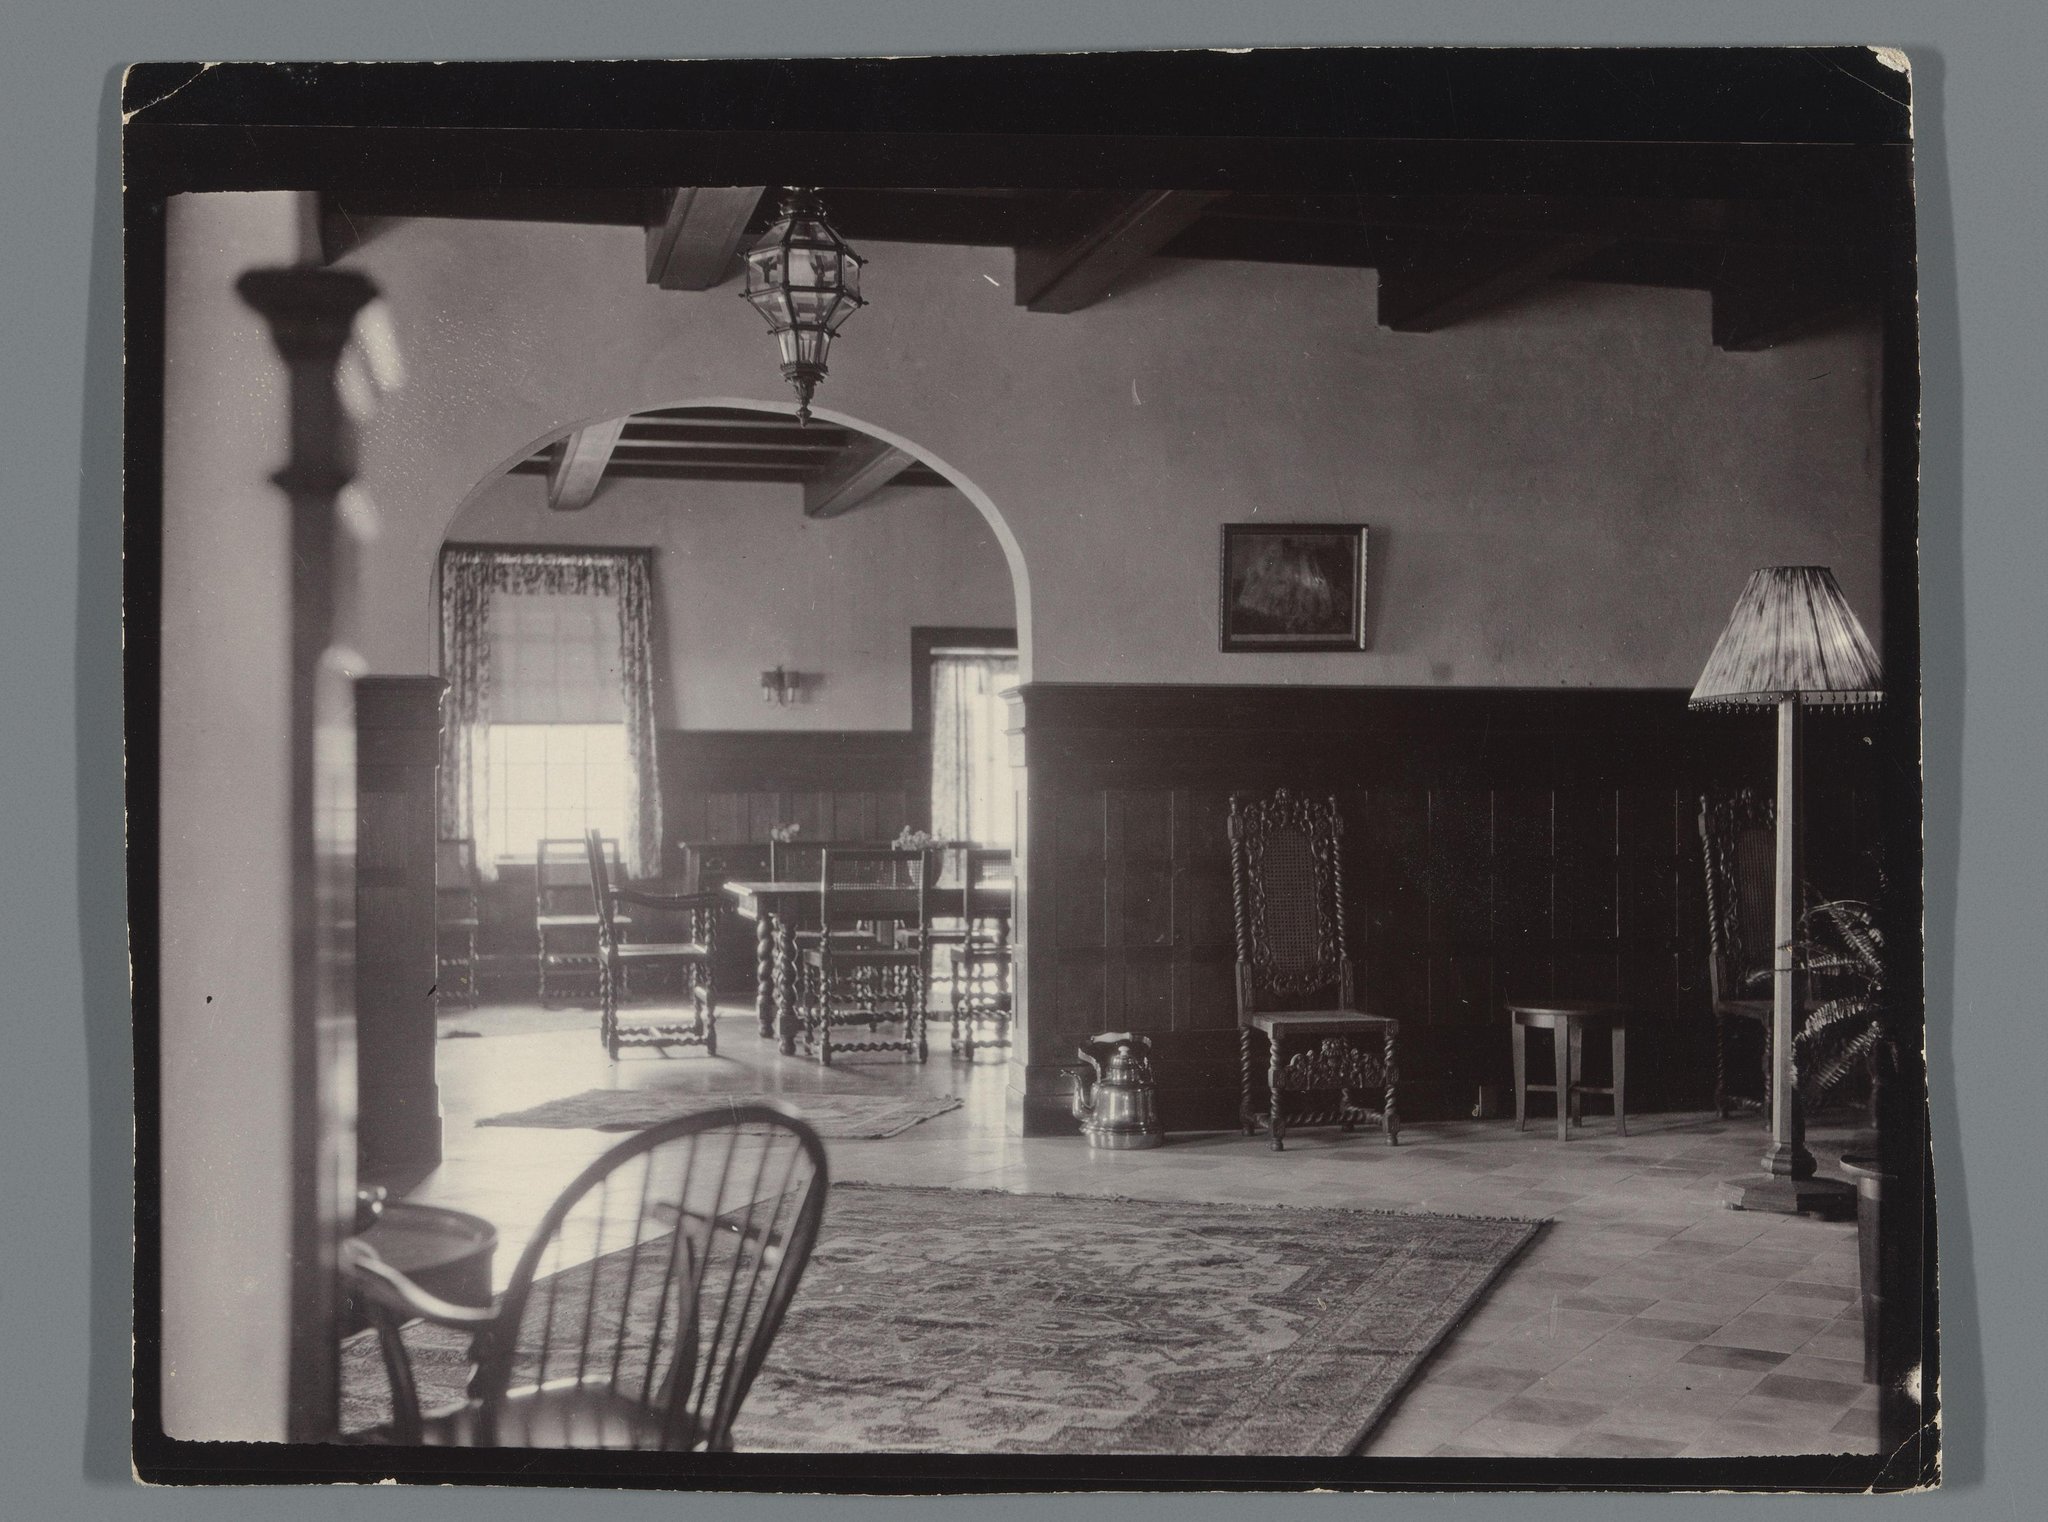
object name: photograph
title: Interieur van een huis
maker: Anonymous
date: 1925-1927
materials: photographic support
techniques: photography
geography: suriname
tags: jetten, familie, moengo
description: Interieur van een huis, waarschijnlijk het huis van het echtpaar Jetten. Onderdeel van het ensemble met foto's van de familie van ingenieur Jetten in de mijnbouwstad Moengo in Suriname.